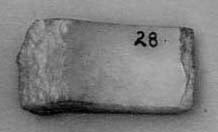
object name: fragment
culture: burmese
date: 1902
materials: jade